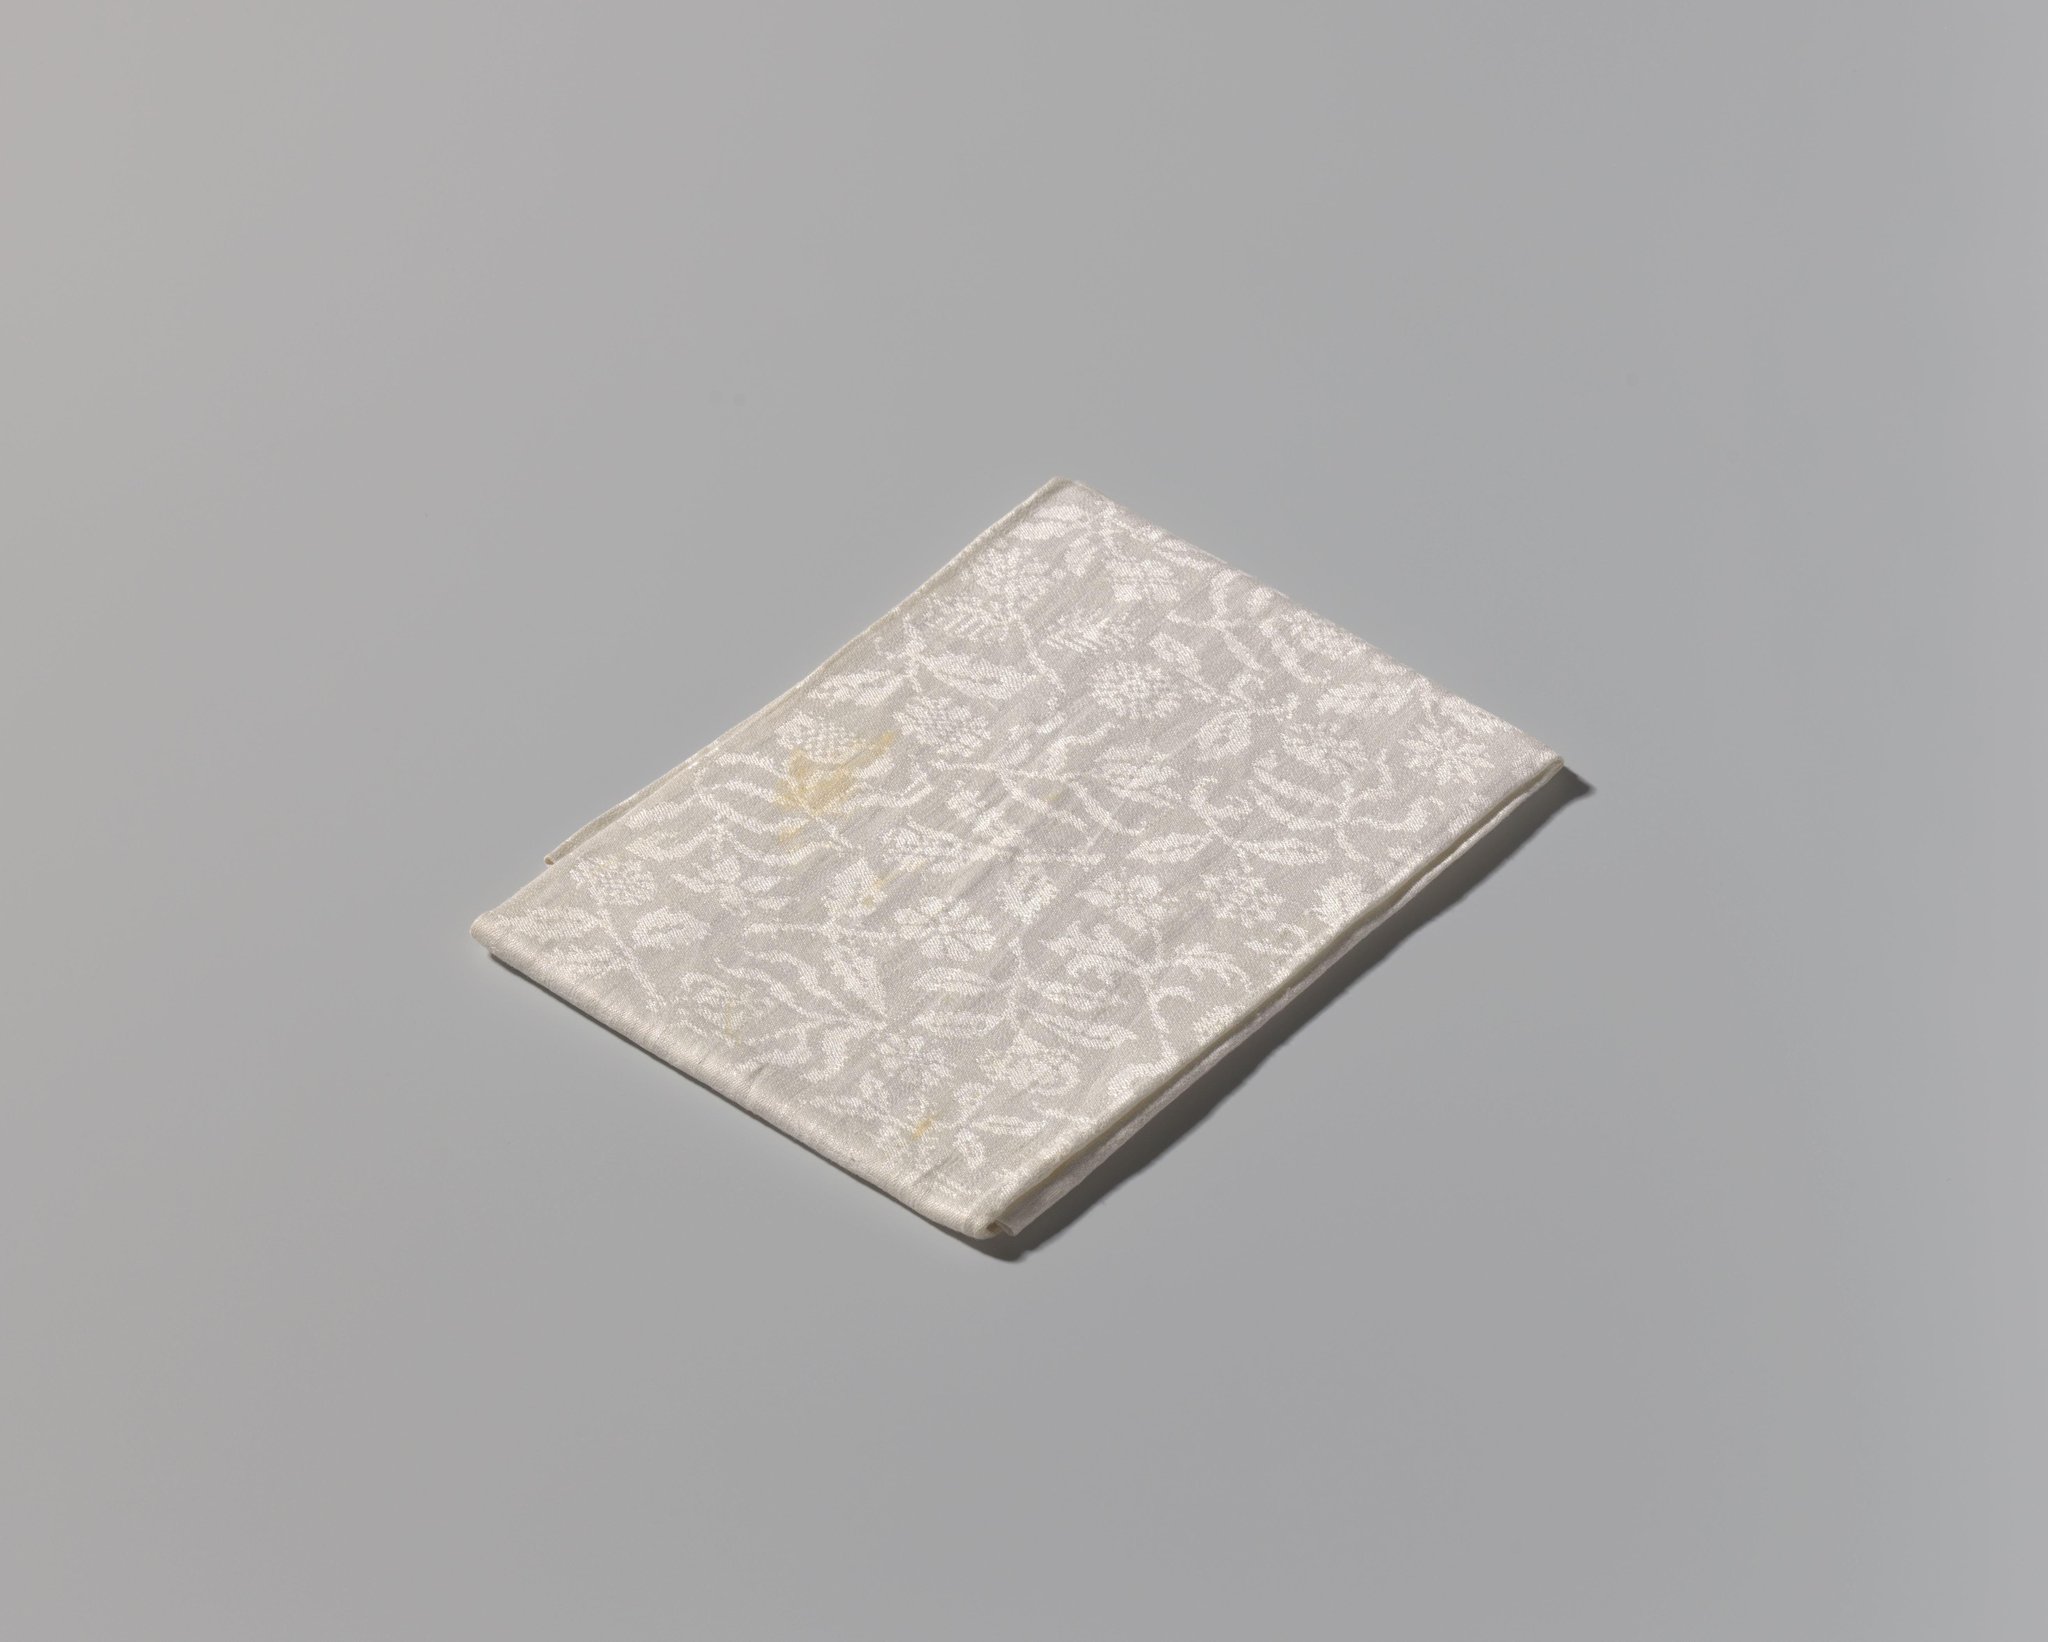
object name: napkin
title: Servet met een bloempatroon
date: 1650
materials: linen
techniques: damask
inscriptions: mark: ‘MJU**-’, mark: ‘12’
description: Servet van linnendamast met een bloempatroon. Middenveld: Het symmetrisch patroon vertoont losse takken met rozen of tulpen, en kievits- of rozetvormige bloemen. Staande randen: symmetrische tekening van slingerende bloemranken en vogels; daarbuiten: blokkenrand.